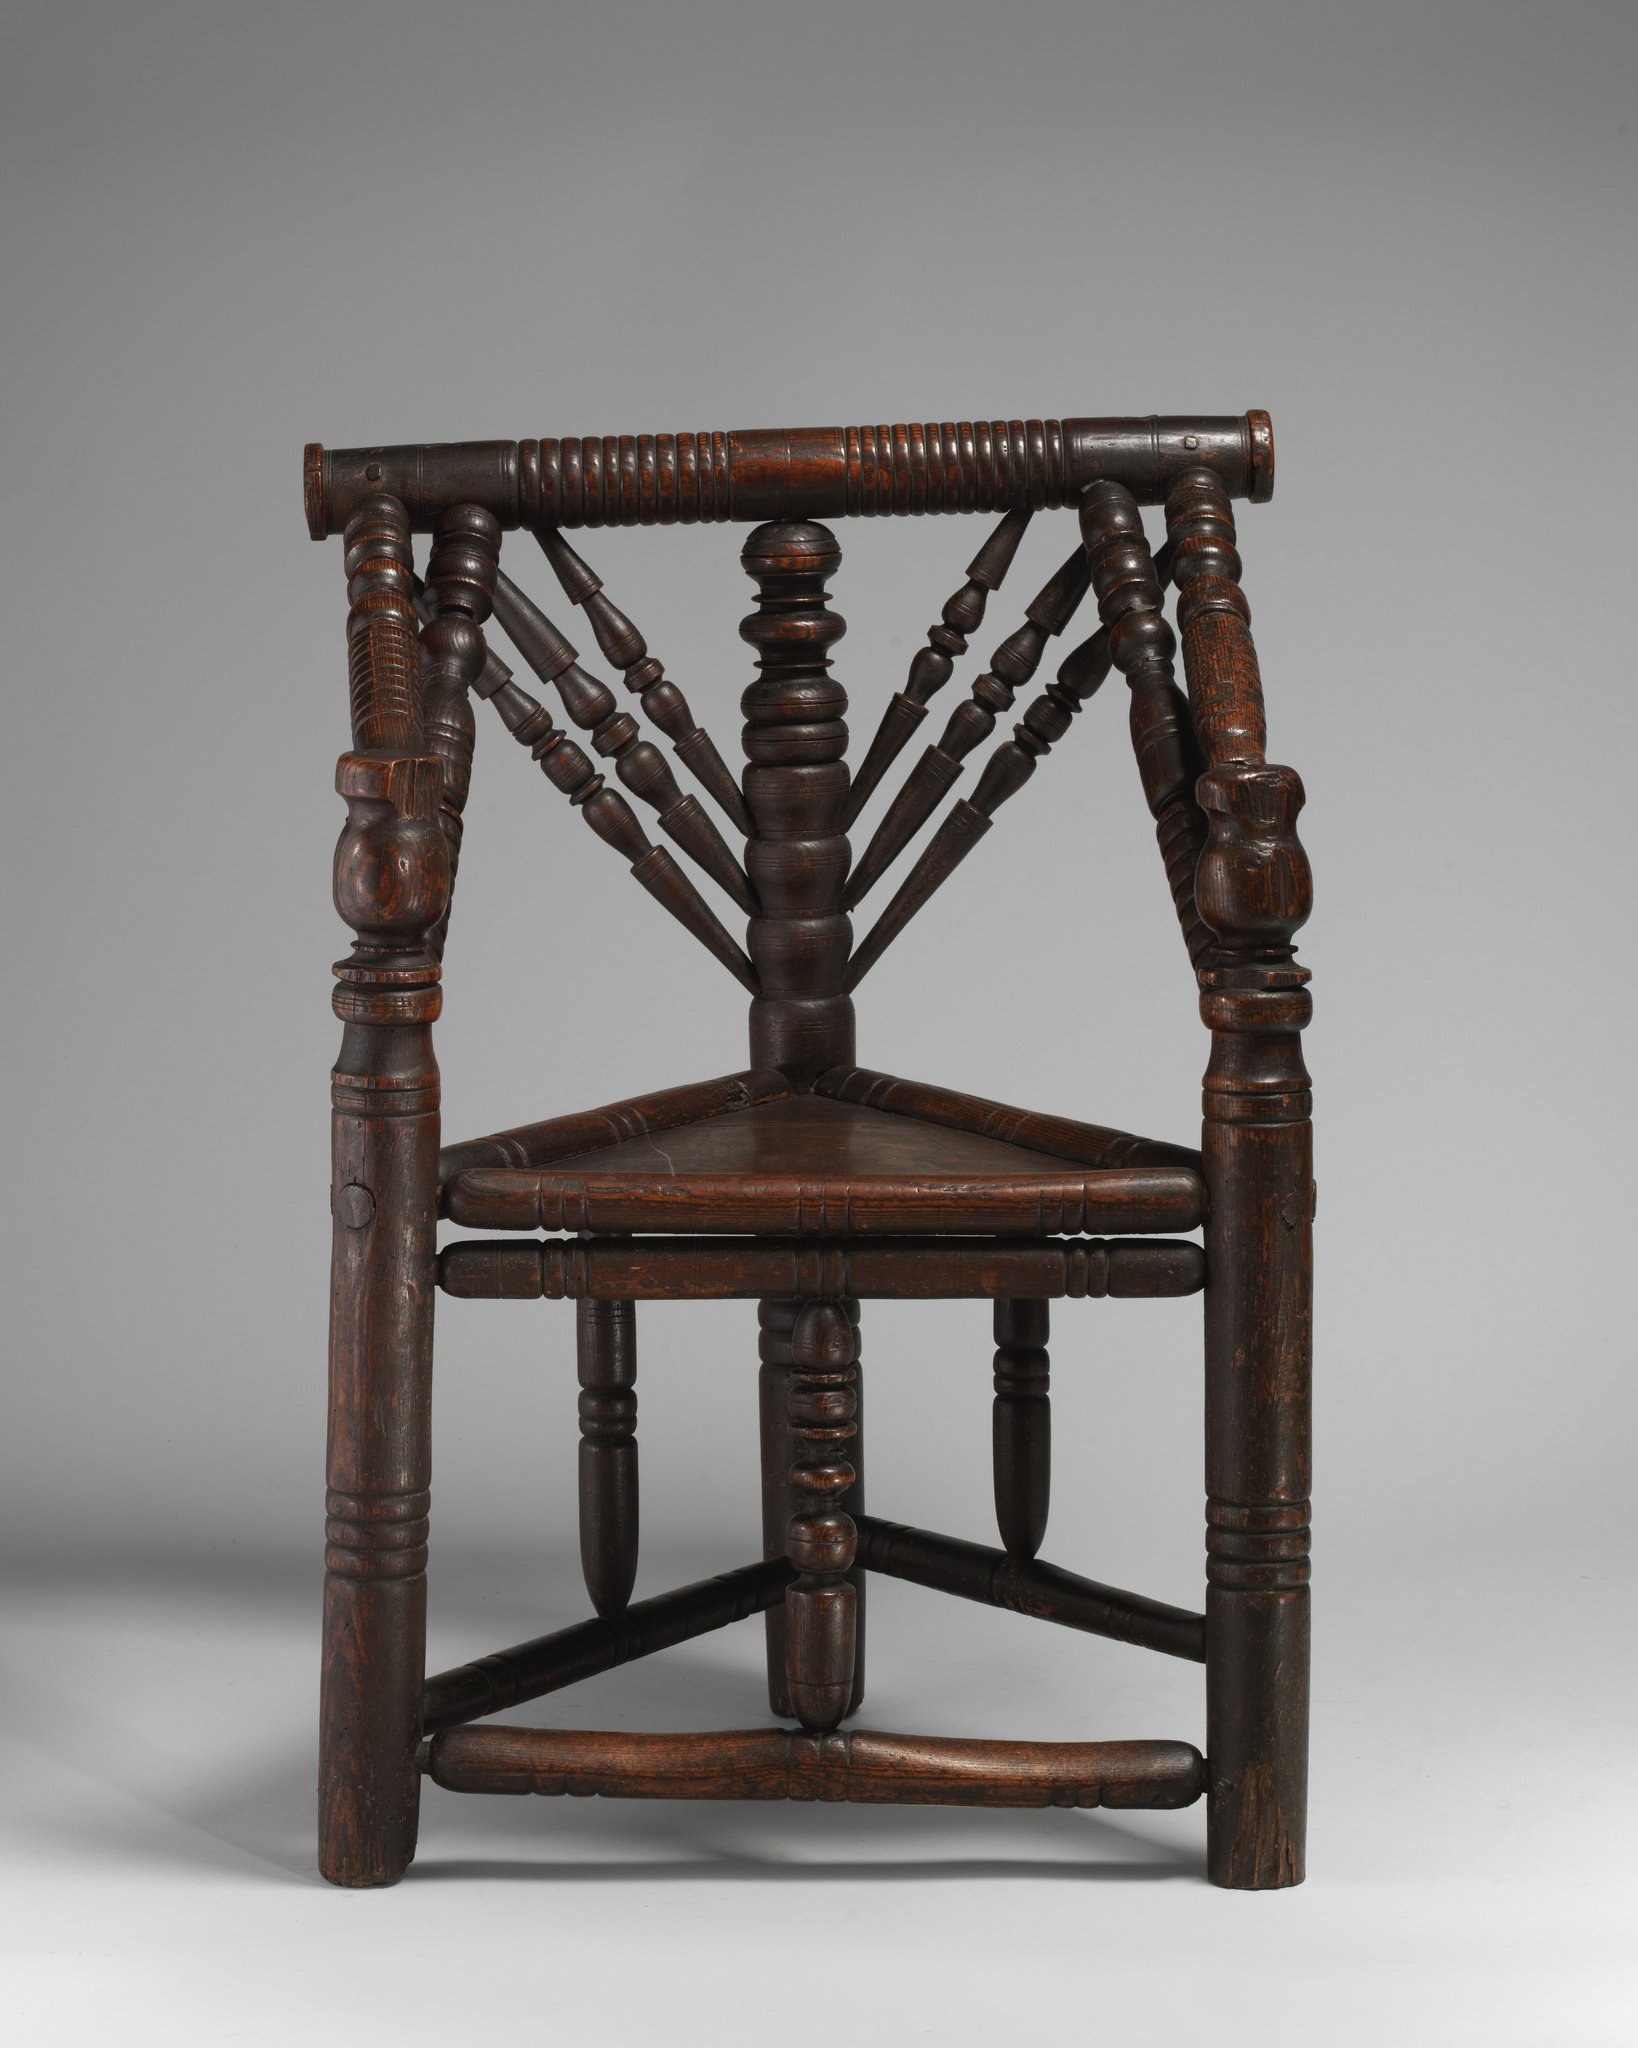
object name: chair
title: Three-legged chair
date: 1567-1633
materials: wood